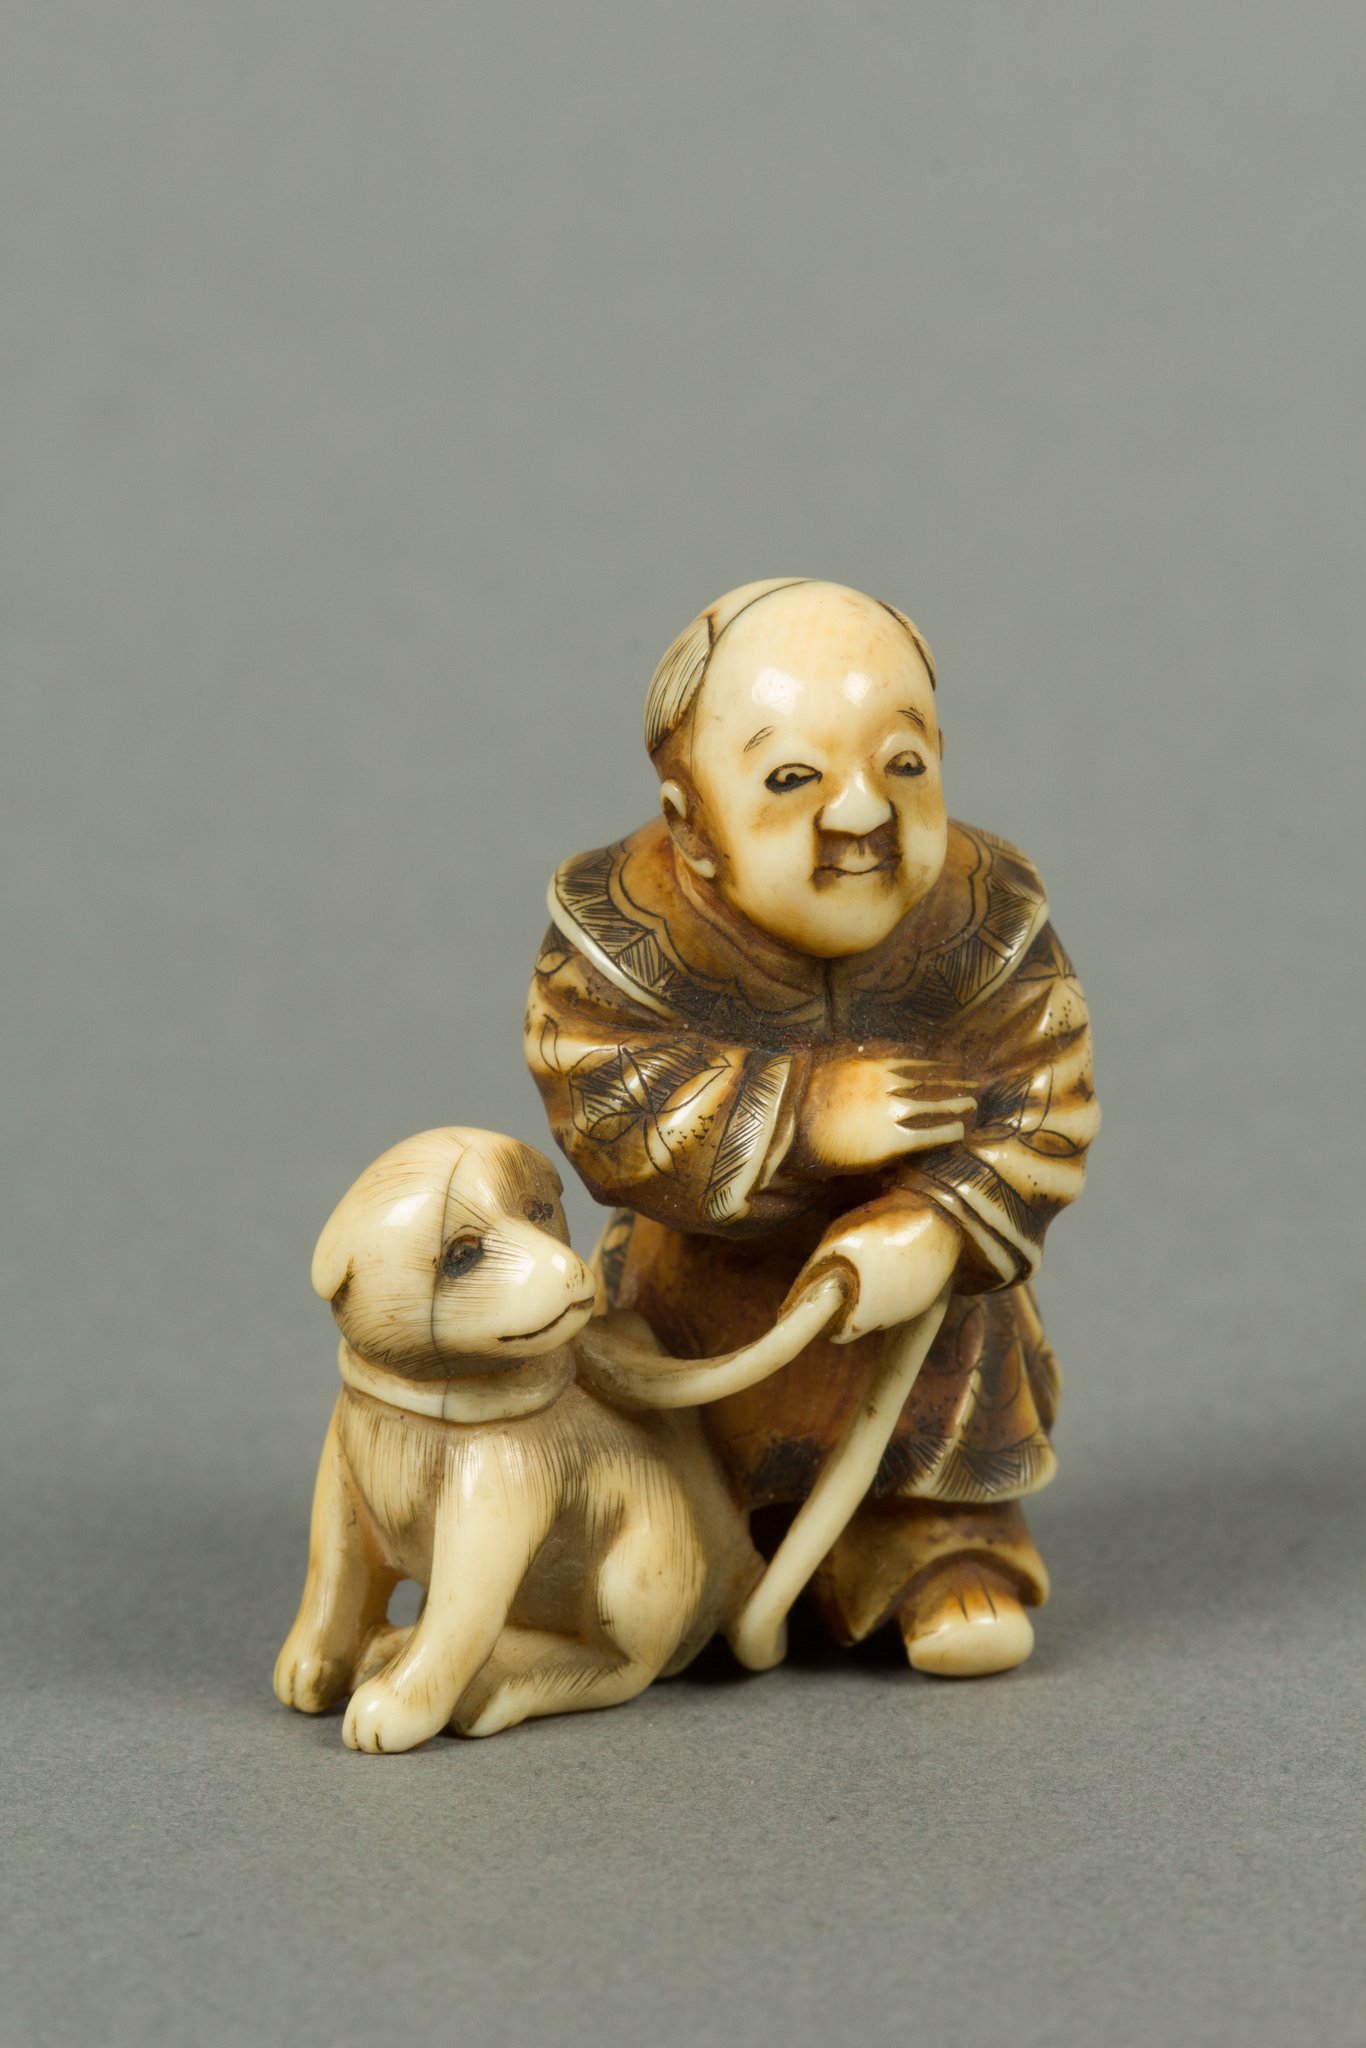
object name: netsuke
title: Netsuke of Boy with a Dog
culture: japanese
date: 1801-1900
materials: ivory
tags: boys,dogs